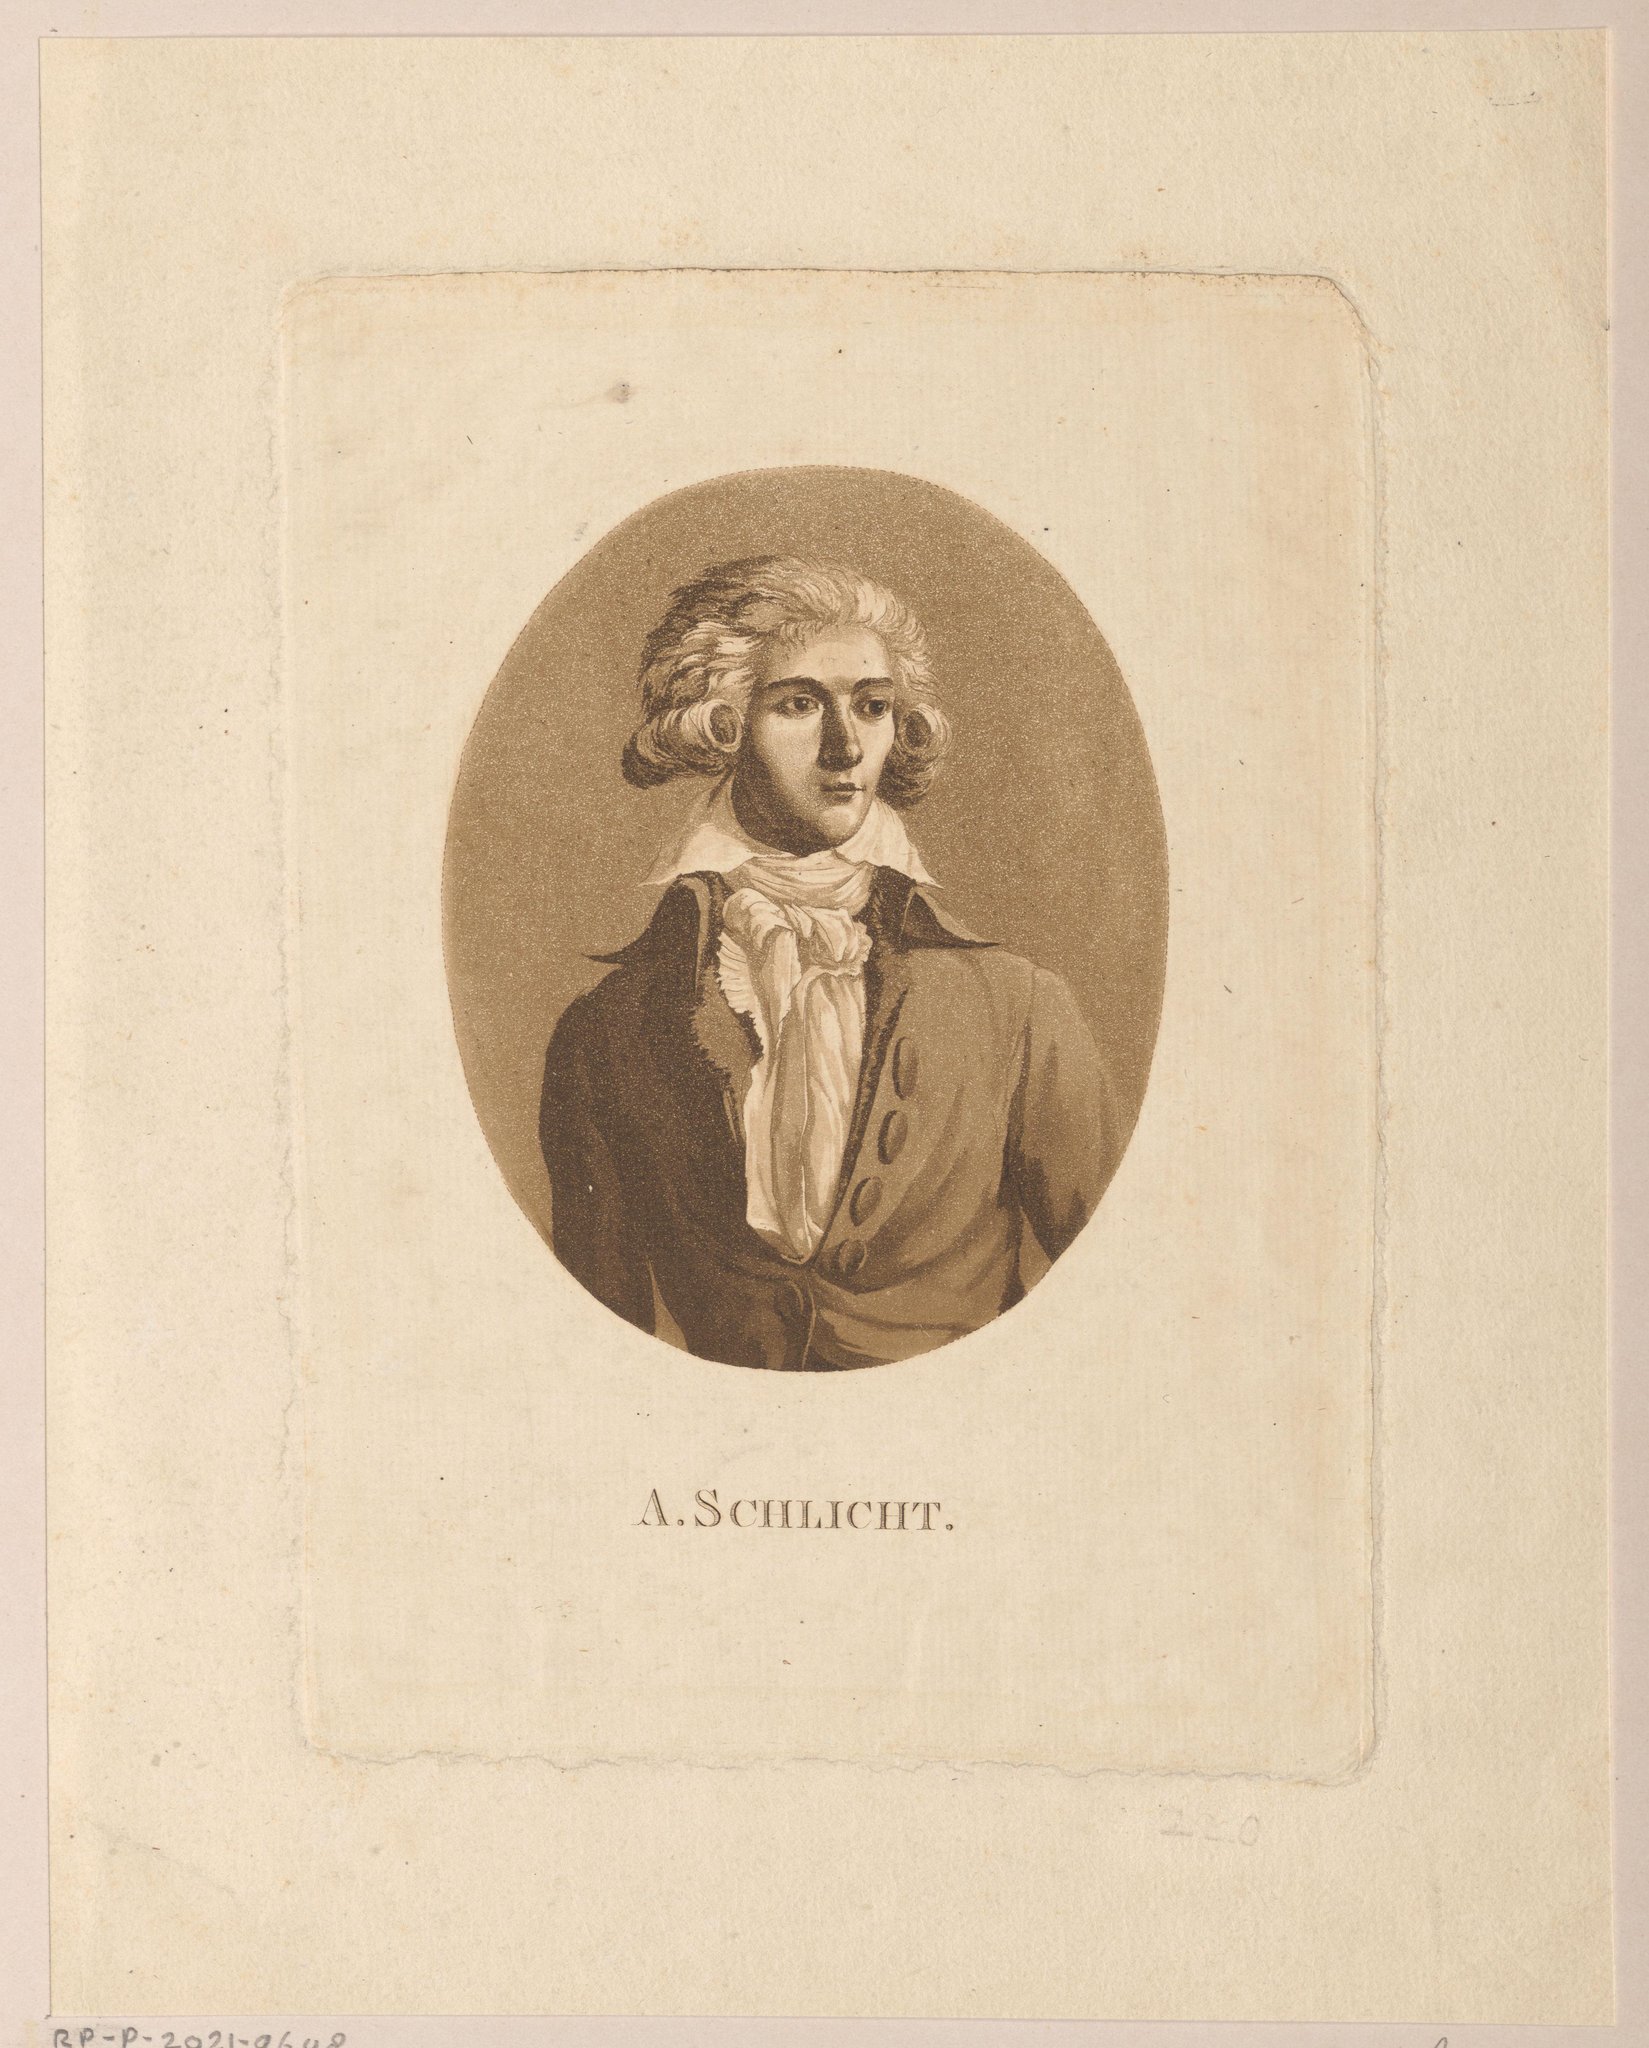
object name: print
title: Portret van Abel Schlicht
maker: Anonymous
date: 1774-1826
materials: paper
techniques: aquatint, etching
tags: print maker, abel schlicht, historical persons, portrait, self-portrait of artist